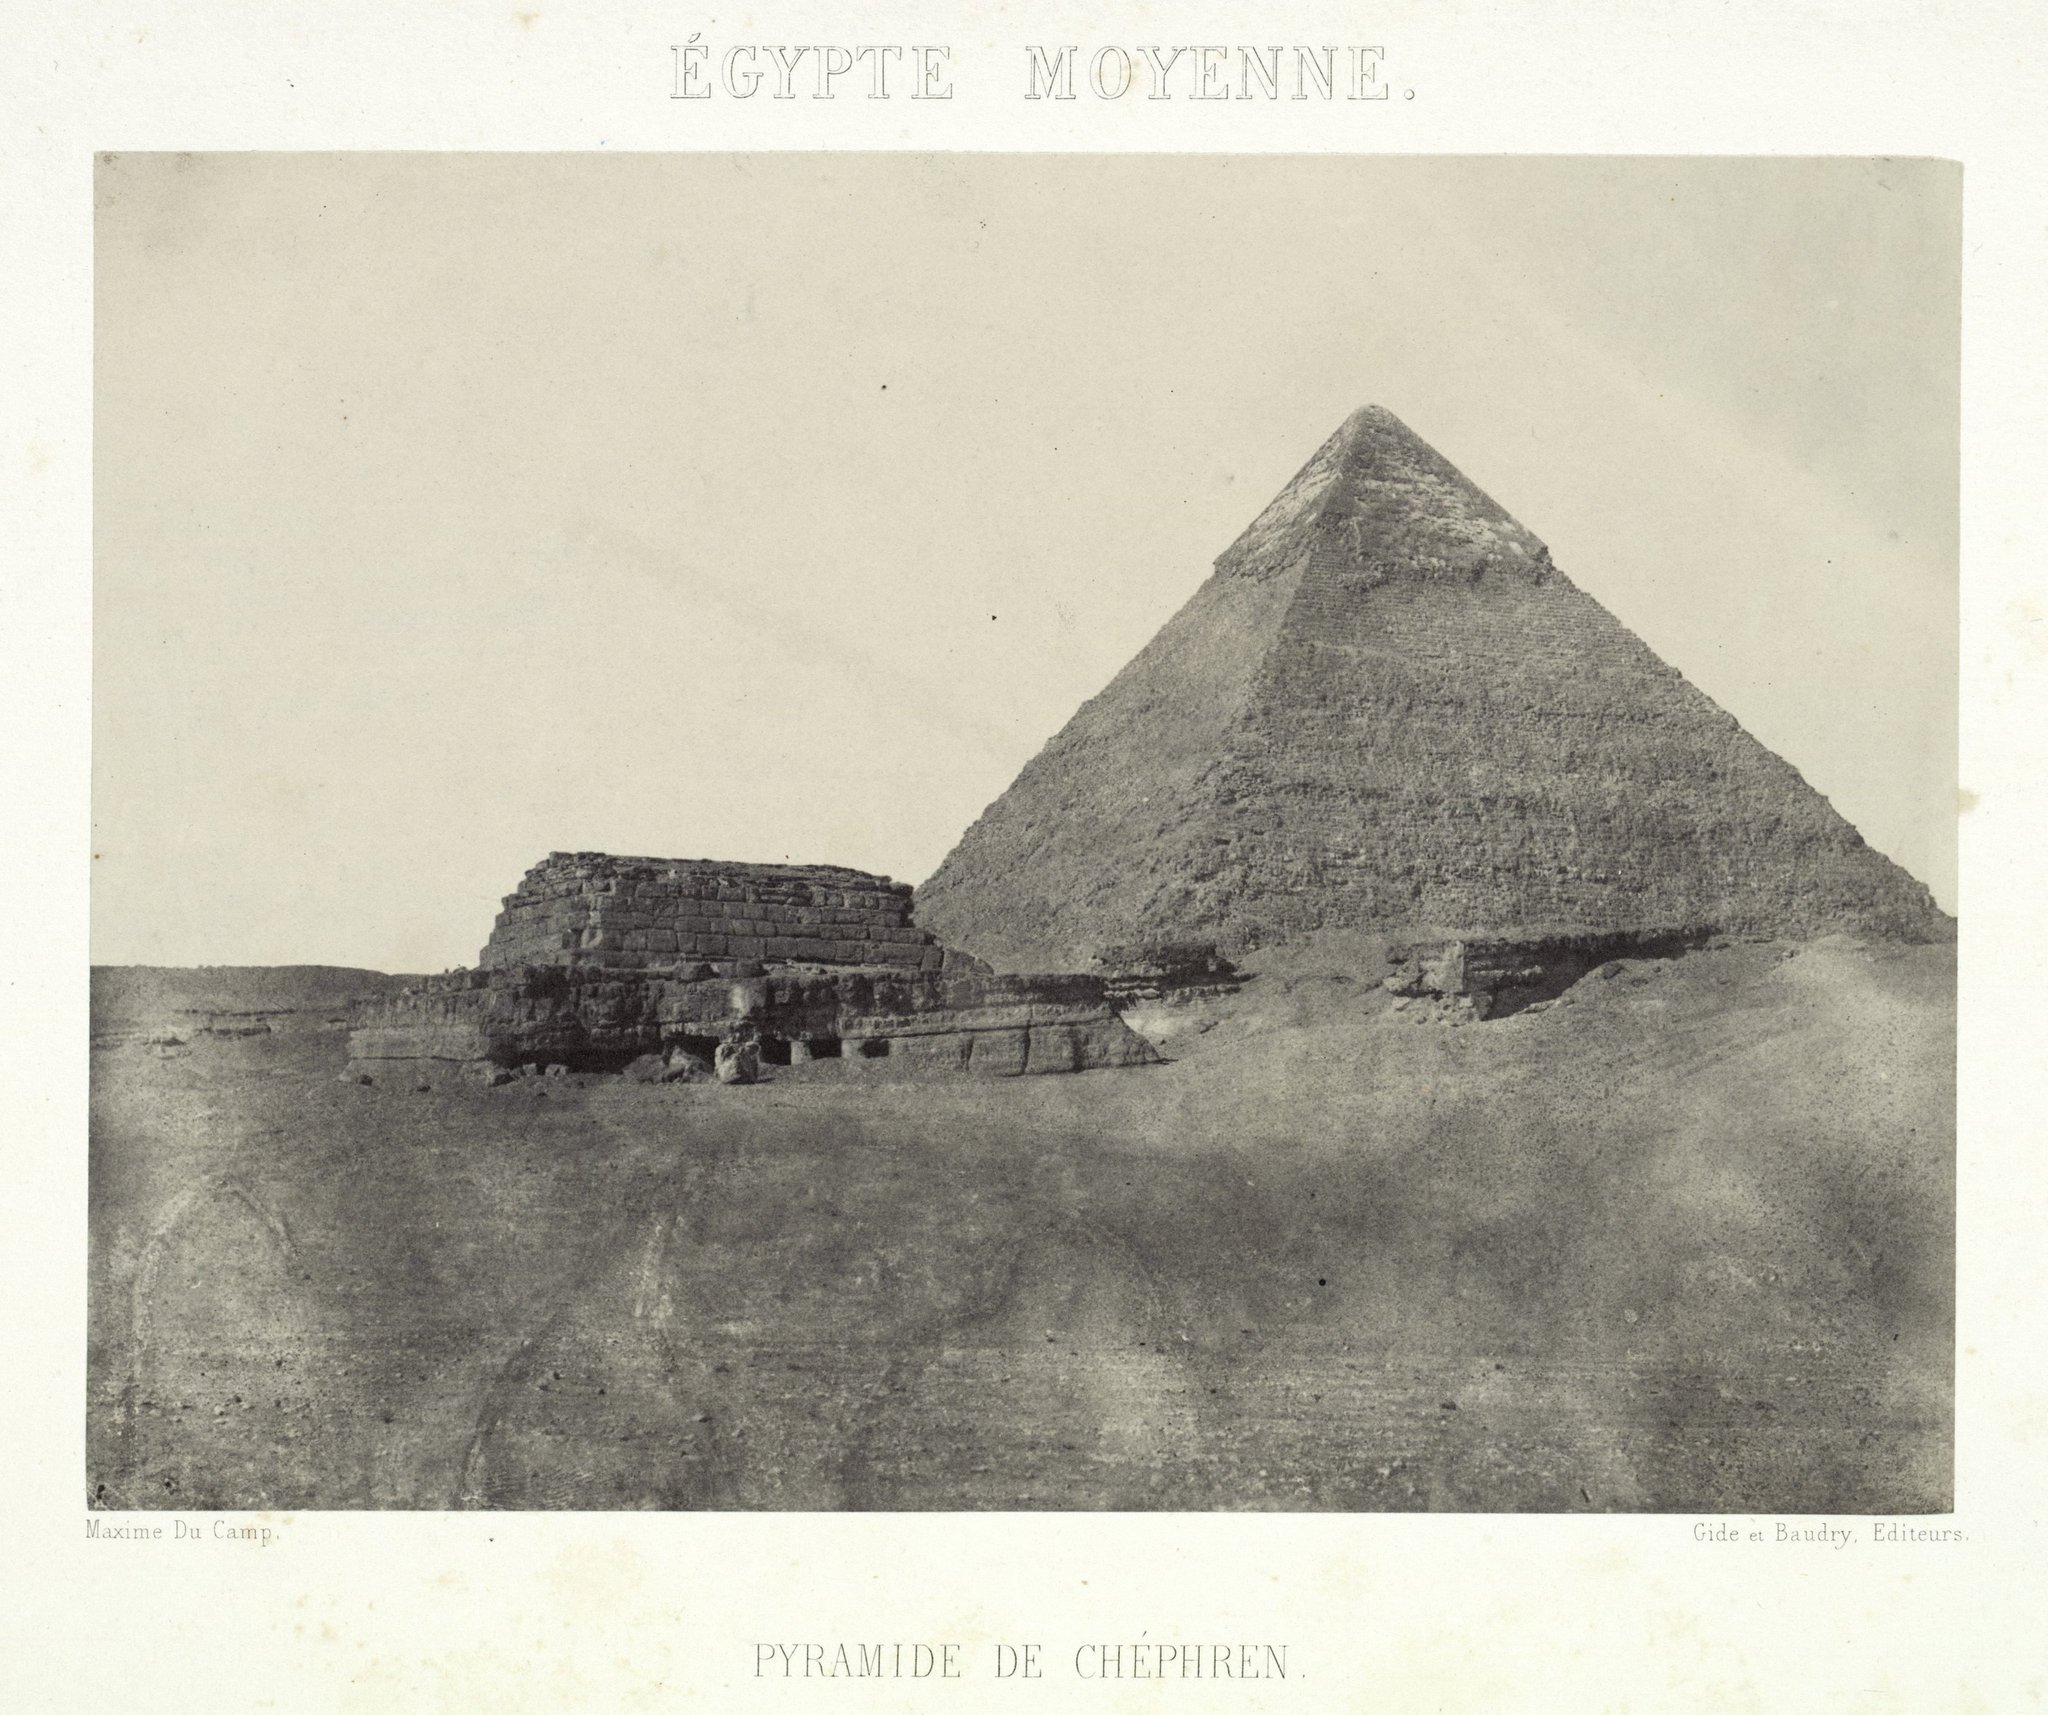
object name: photograph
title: Égypte Moyenne. Pyramide de Chéphren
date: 1849-1851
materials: cardboard, paper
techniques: salted paper print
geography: lille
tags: egyptian pyramids (wonder of the world)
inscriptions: inscription: ‘Maxime Du Camp./ Gide et Baudry, Editeurs./ ÉGYPTE MOYENNE./ PYRAMIDE DE CHÉPHREN./ Imprimerie Photographique de Blanquard-Evrard, à Lille./ Pl. 10.’